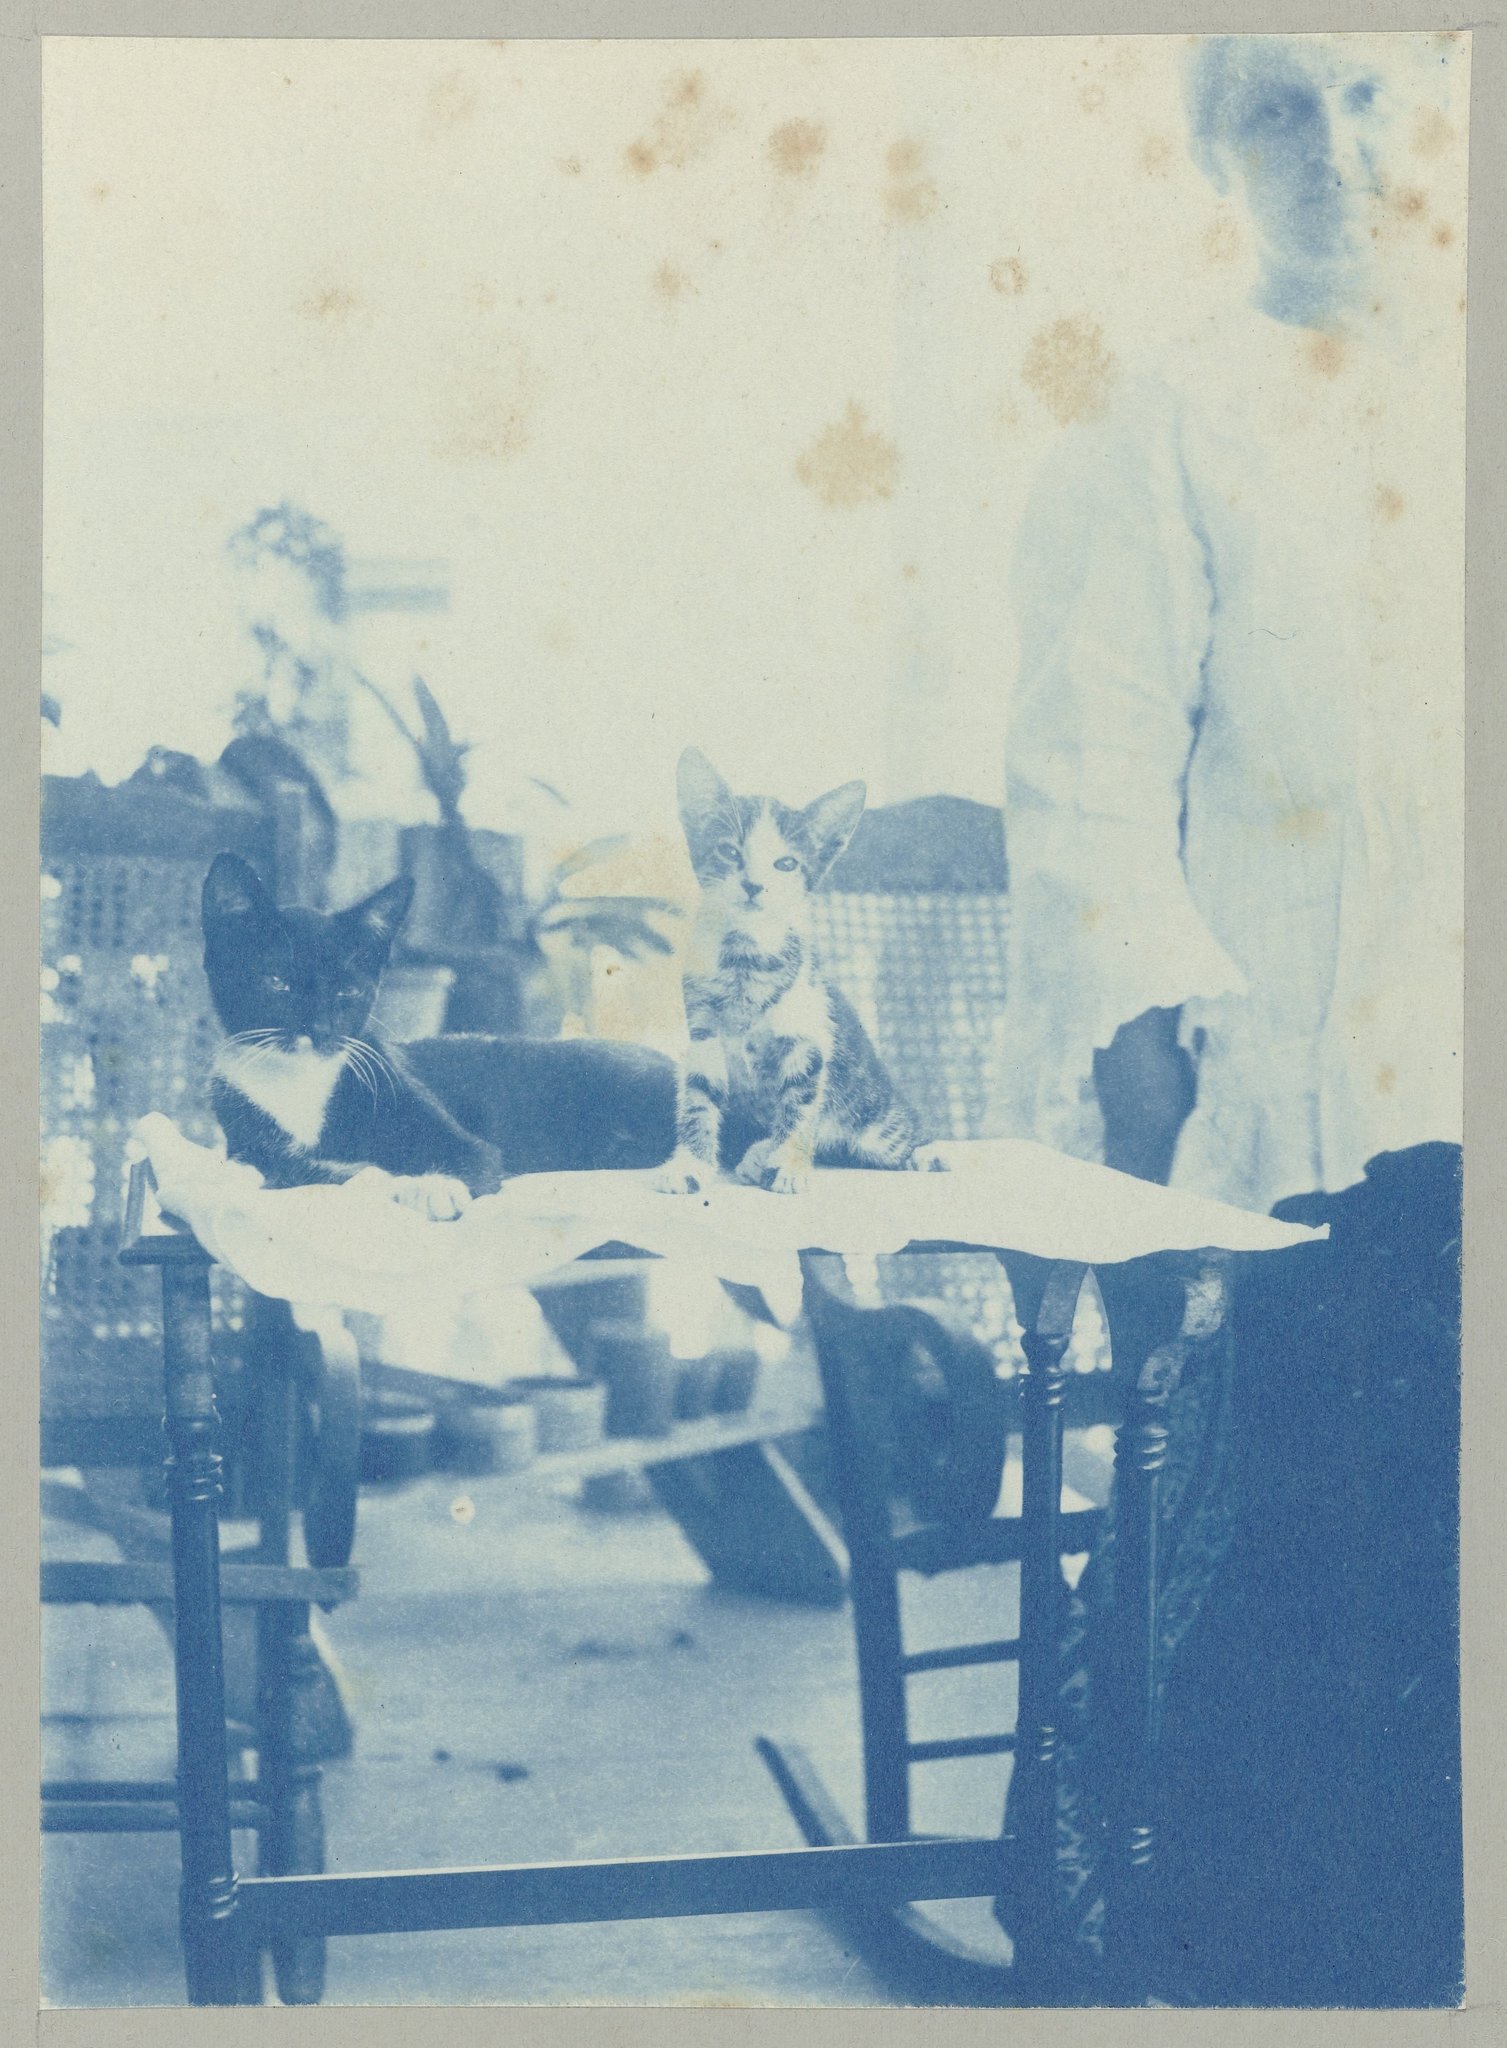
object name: photograph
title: Onze katten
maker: hendrik doijer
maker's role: engineer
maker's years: 1863-1925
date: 1903-1910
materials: photographic support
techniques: cyanotype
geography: suriname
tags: suriname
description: Twee katten op een tafeltje, huisdieren op het balkon van het huis (van de familie Doijer?) in de Oranjestraat te Paramaribo. Rechts een staande vrouw. Onderdeel van het fotoalbum Souvenir de Voyage (deel 2), over het leven van de familie Doijer in en rond de plantage Ma Retraite in Suriname in de jaren 1903-1910.